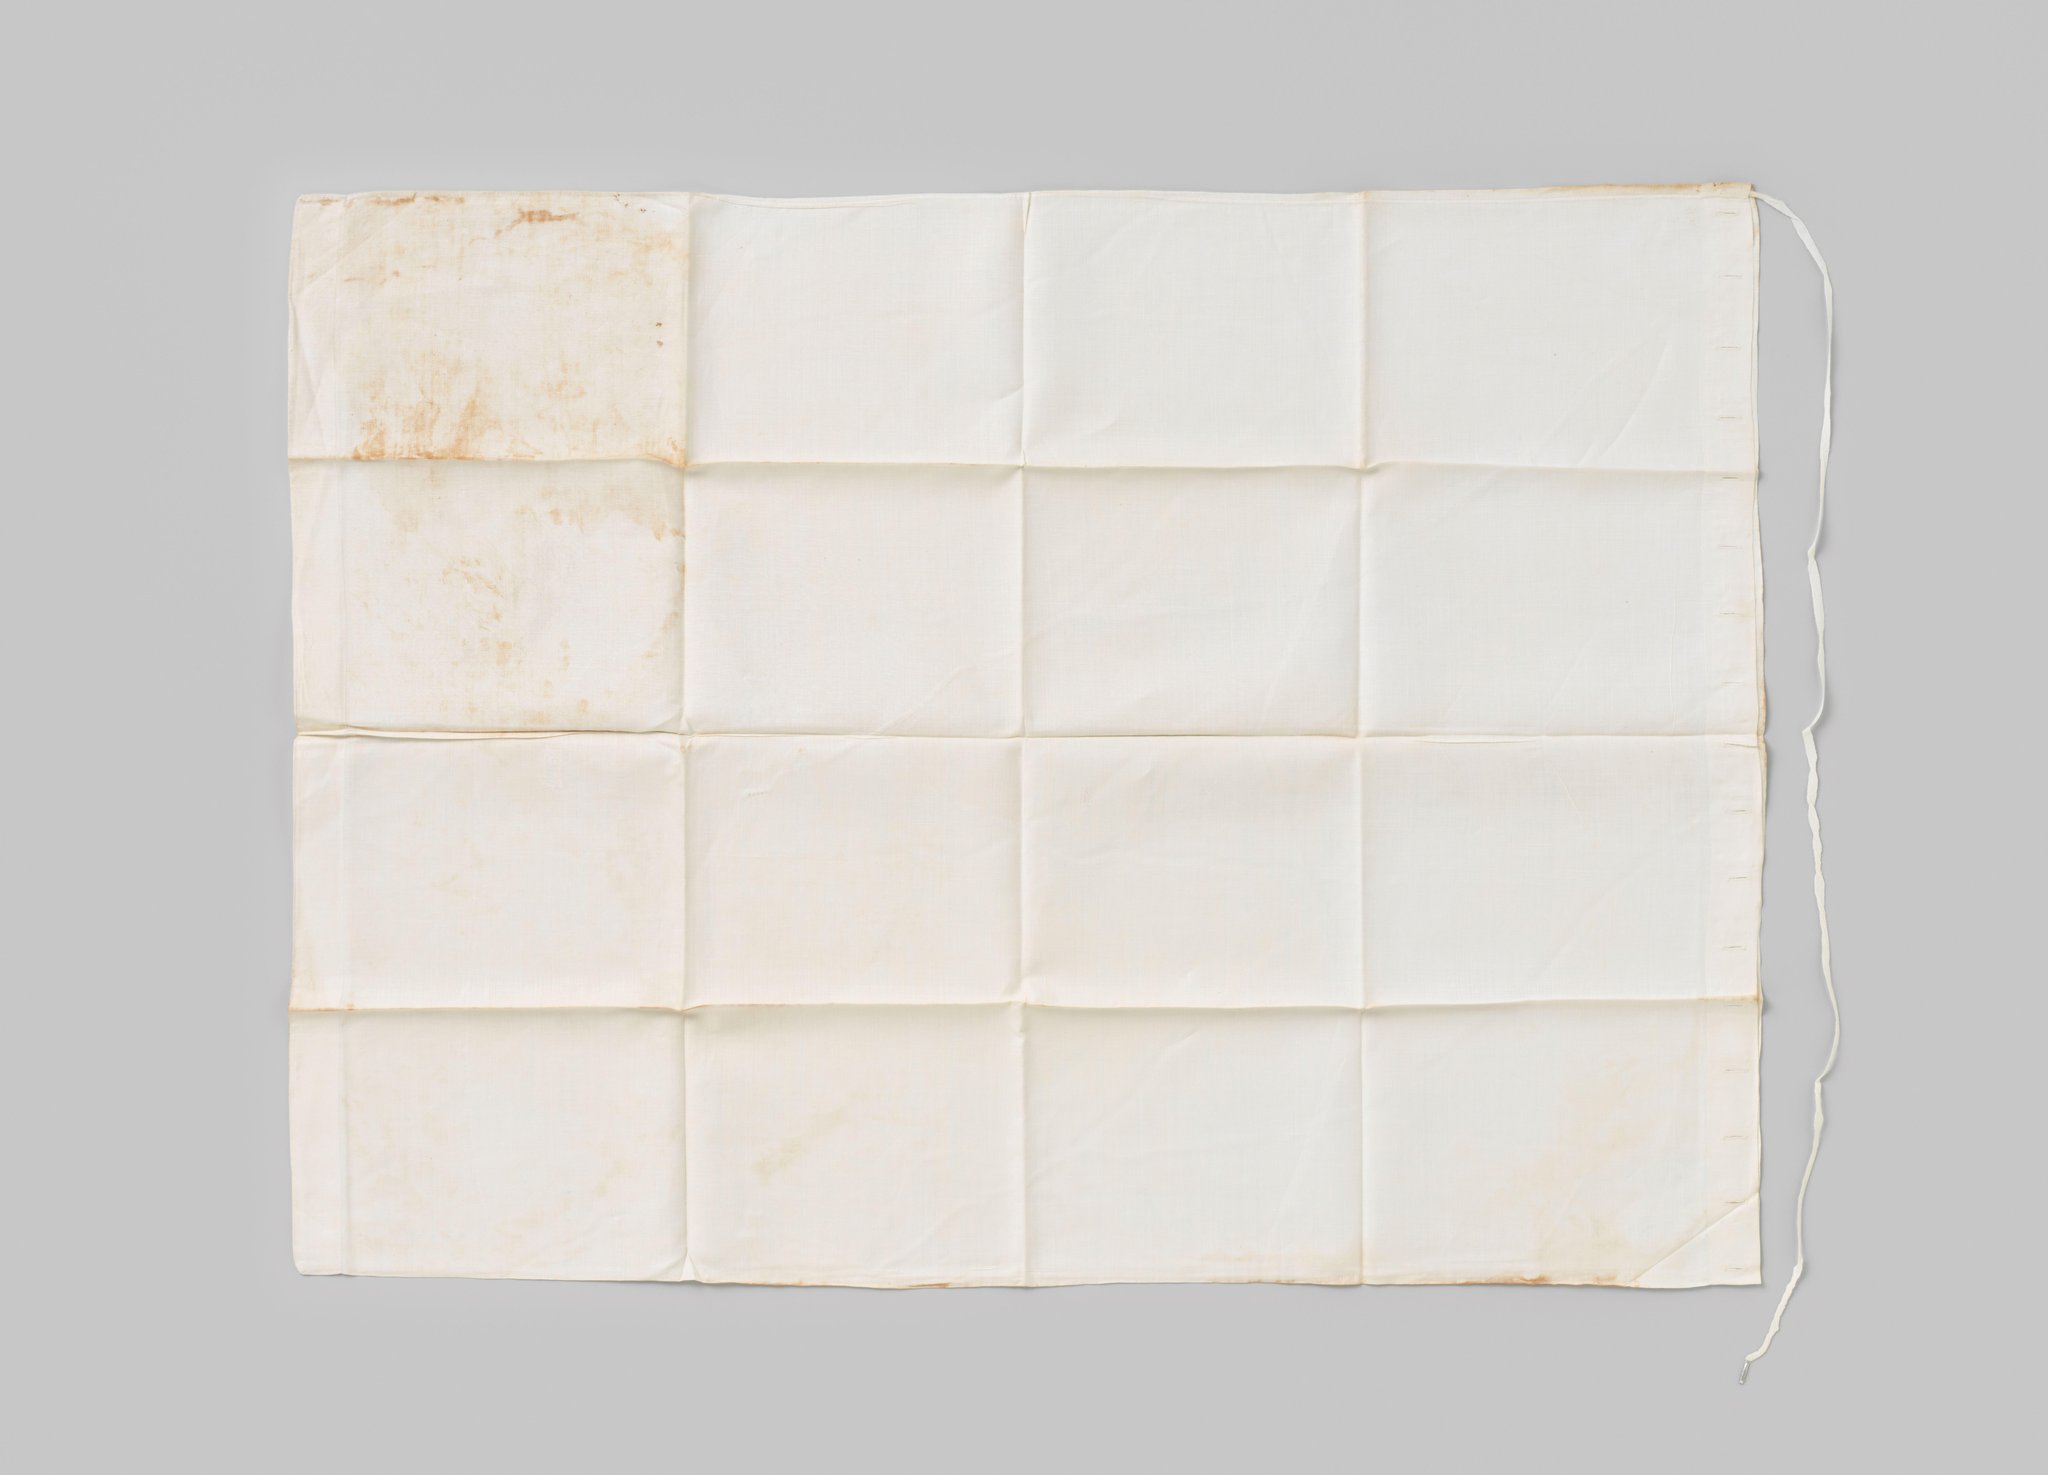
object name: sloop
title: Sloop van linnen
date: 1820-1870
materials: linen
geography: northern netherlands